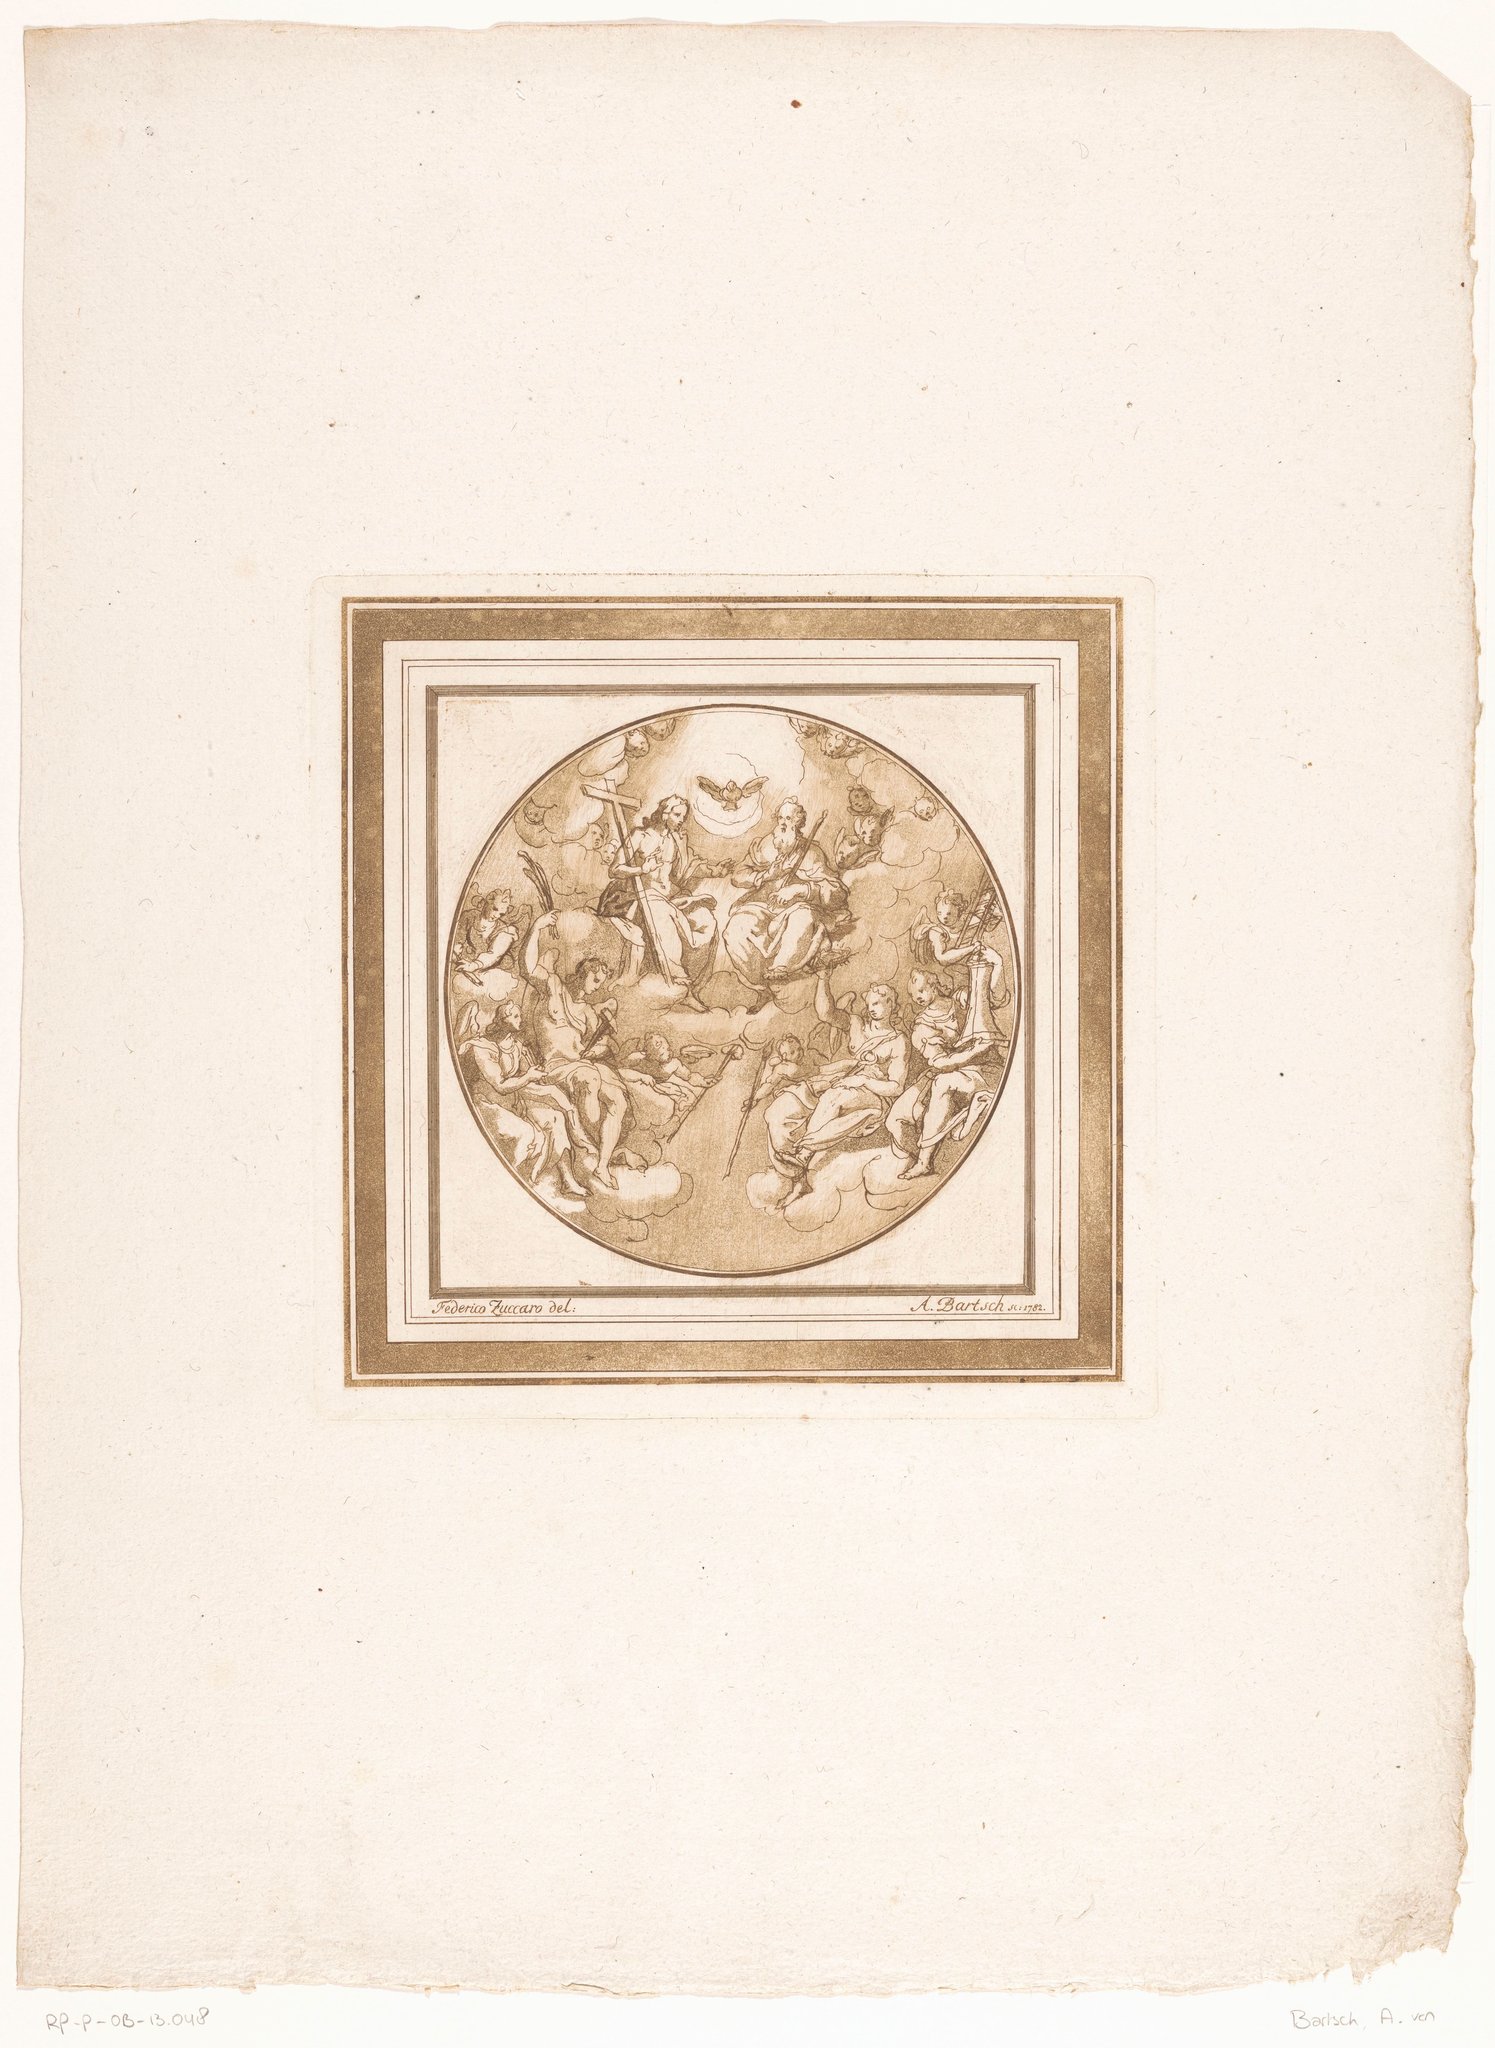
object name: print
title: Heilige Drie-eenheid omringd door engelen met passiewerktuigen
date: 1782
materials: paper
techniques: aquatint, etching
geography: italy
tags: 'arma christi', trinity in which god the father and christ are represented as persons, the holy ghost as dove, angels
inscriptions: collector's mark: Lugt 240